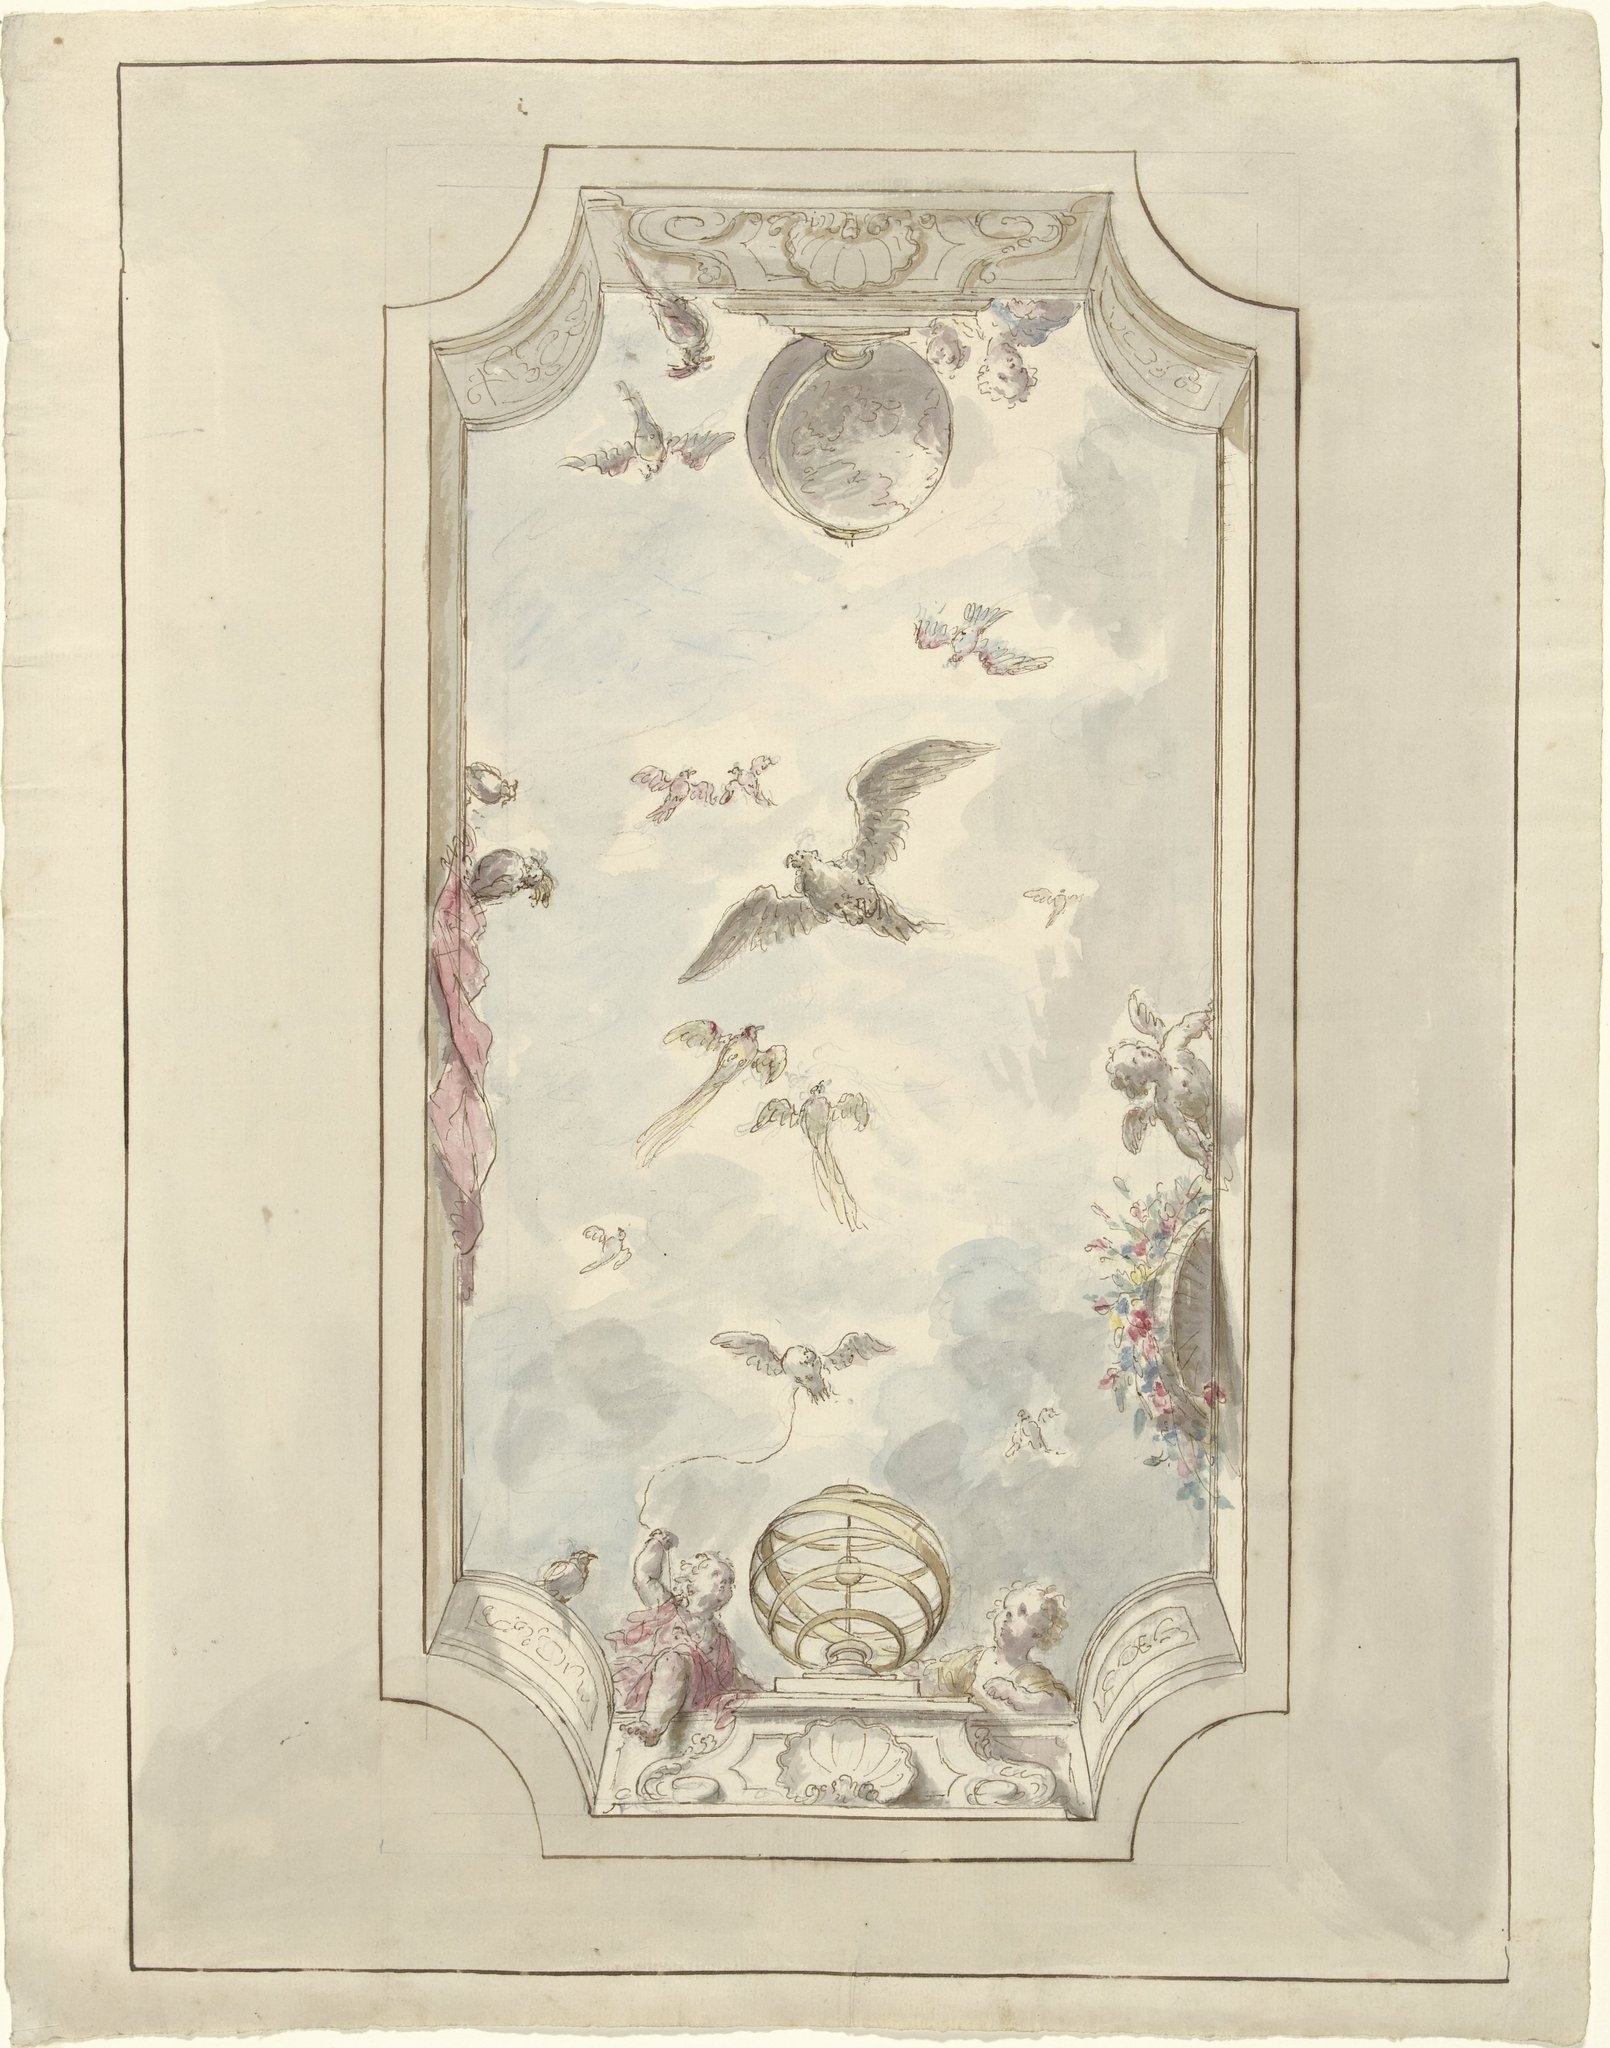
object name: design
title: Ontwerp voor een plafondschildering met gezicht langs balustrade in de lucht met vogels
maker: dionys van nijmegen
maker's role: draughtsman, painter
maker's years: 1705-1798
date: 1715-1798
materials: ink, paper, pencil, watercolor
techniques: brush, pen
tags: birds